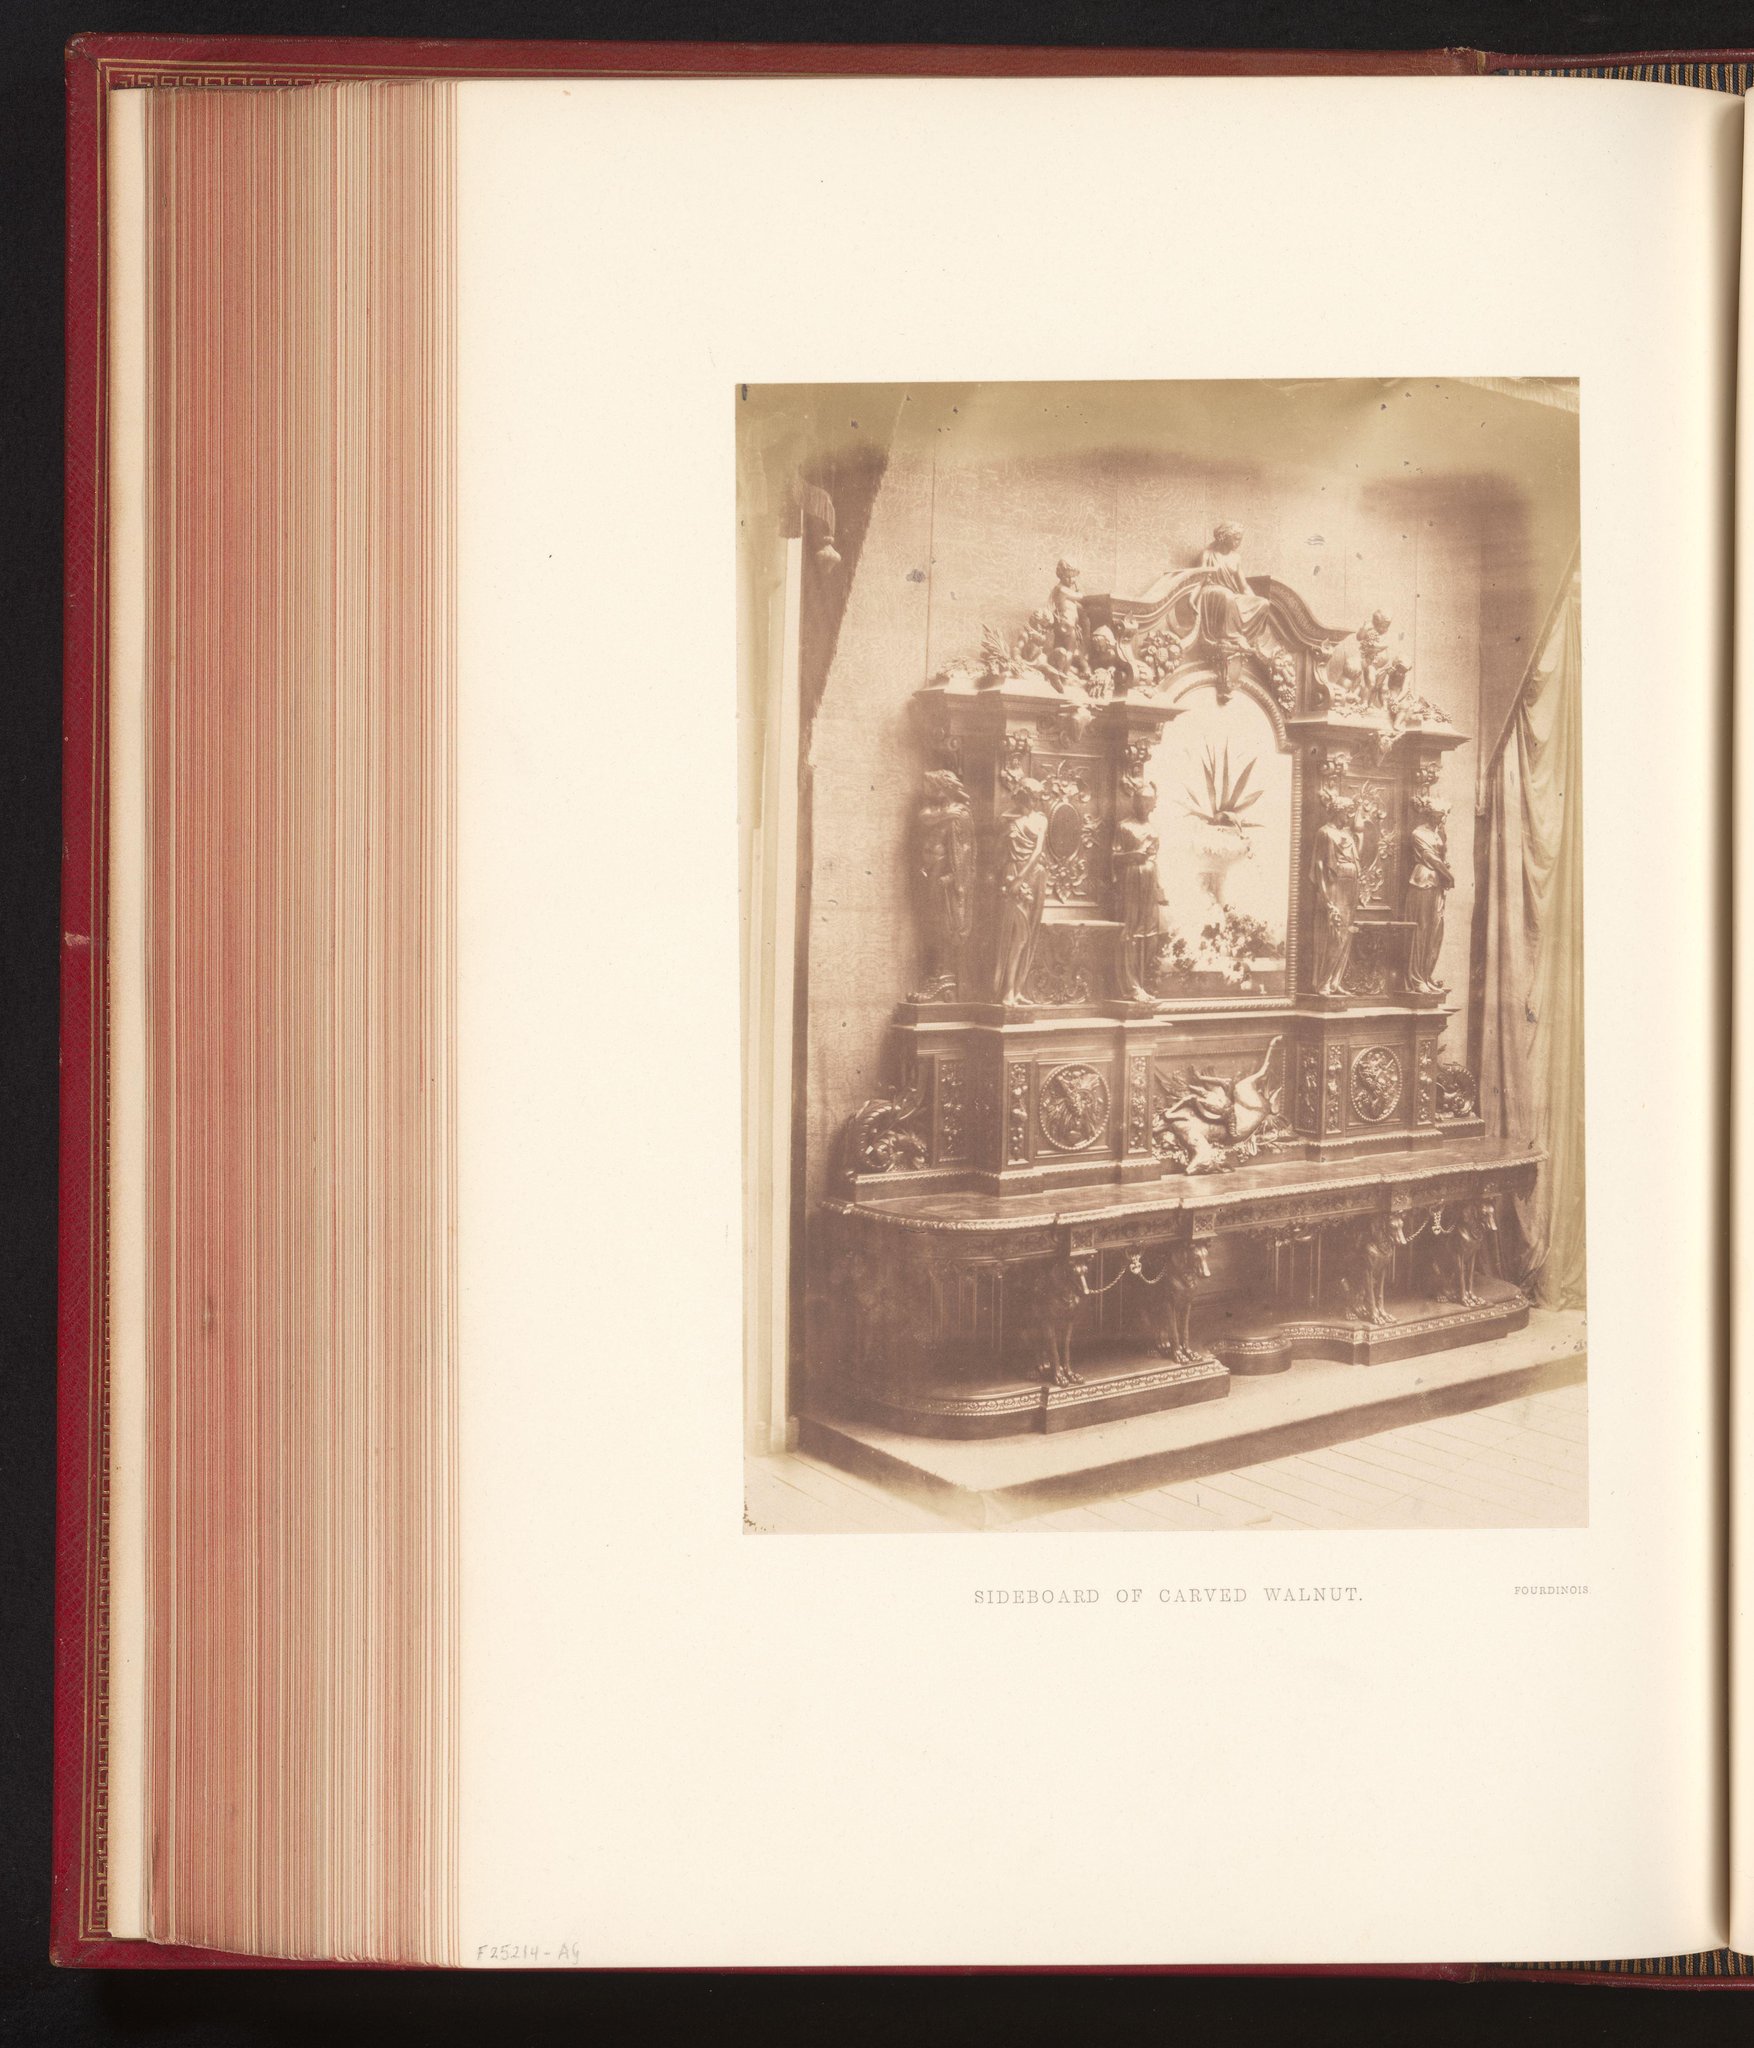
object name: photograph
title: Sideboard of Carved Walnut. Fourdinois.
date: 1851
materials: photographic support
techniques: salted paper print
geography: london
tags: shelves, rack, sideboard, london